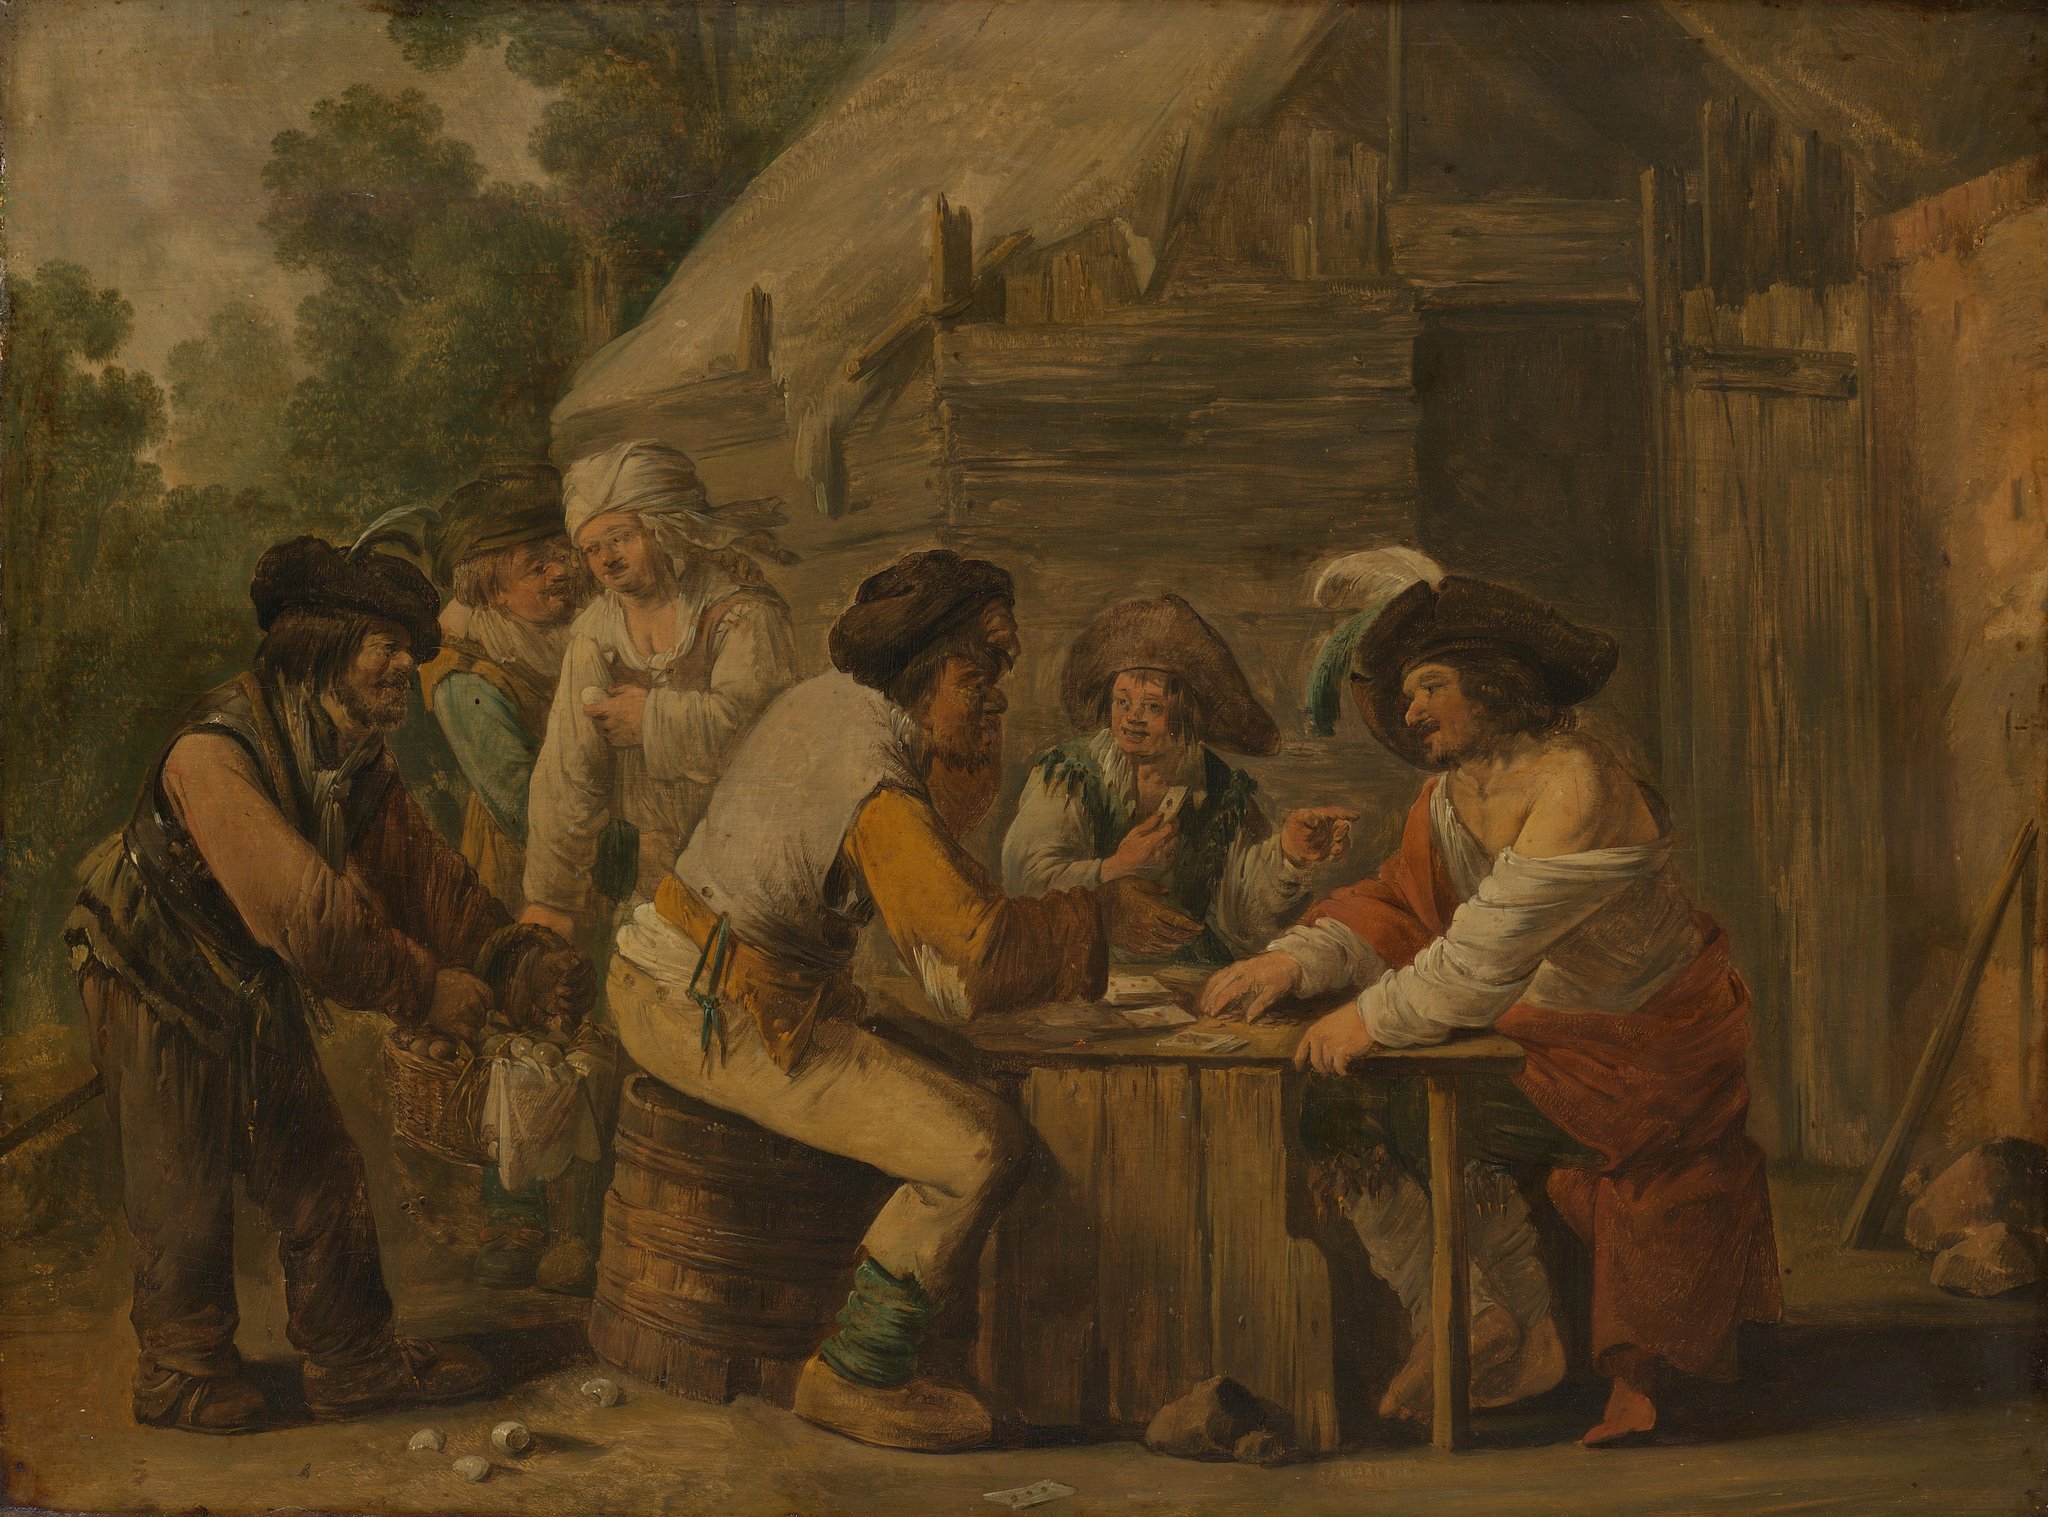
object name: painting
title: The Card Players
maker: andries both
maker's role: draughtsman, painter, print maker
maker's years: 1612-1642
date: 1630-1635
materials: oil, panel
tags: pavement, terrace in front of inn or restaurant, playing-cards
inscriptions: signature, lower centre, on the table (A and B ligated): ‘ABoth’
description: De kaartspelers. Drie mannen zitten rond een tafel voor een schuur te kaarten. Links een vrouw bij een man die een mand met eieren bij zich draagt.